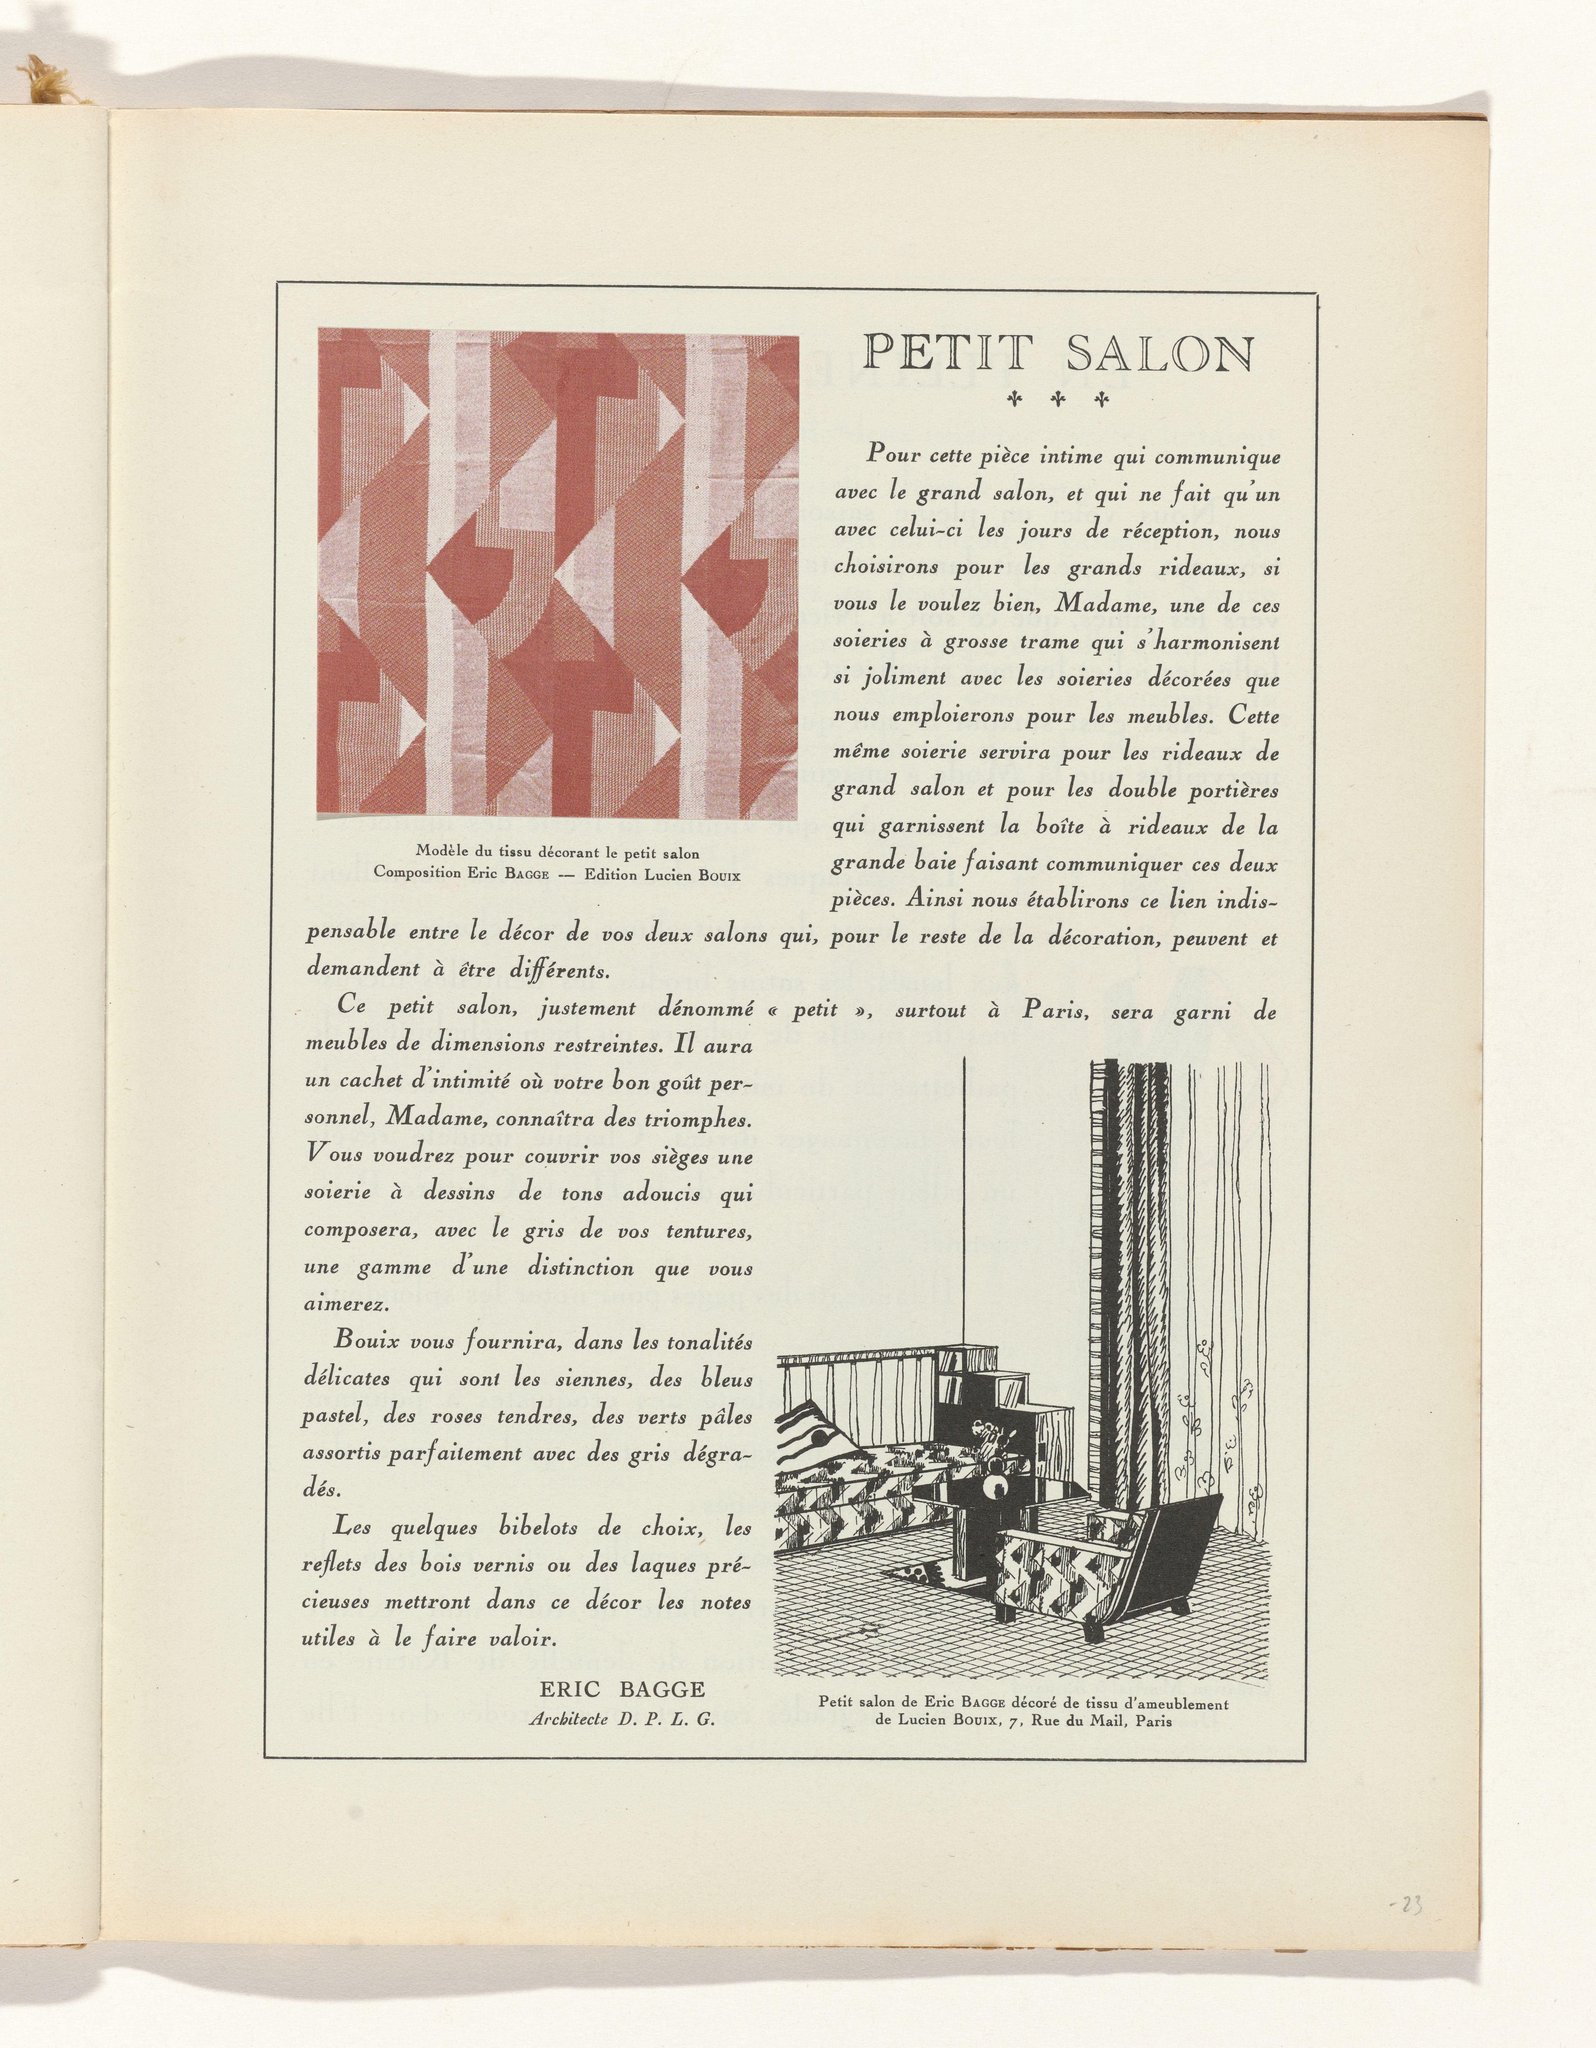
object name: fashion print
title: Art - Goût - Beauté, Feuillets de l' élégance féminine, Novembre 1928, No. 99, 9e Année, p. 23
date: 1928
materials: paper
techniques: printing, lithograph, photography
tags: fashion plates, furniture and household effects, textile fabric, cloth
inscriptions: title: ‘PETIT SALON’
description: Rechtsonder: kleine salon van Eric Bagge versierd met stoffering van Lucien Bouix. Linksboven: voorbeeld van een stof waarmee de kleine salon is bekleed. Pagina uit het modetijdschrift Art-Goût-Beauté (1920-1933).